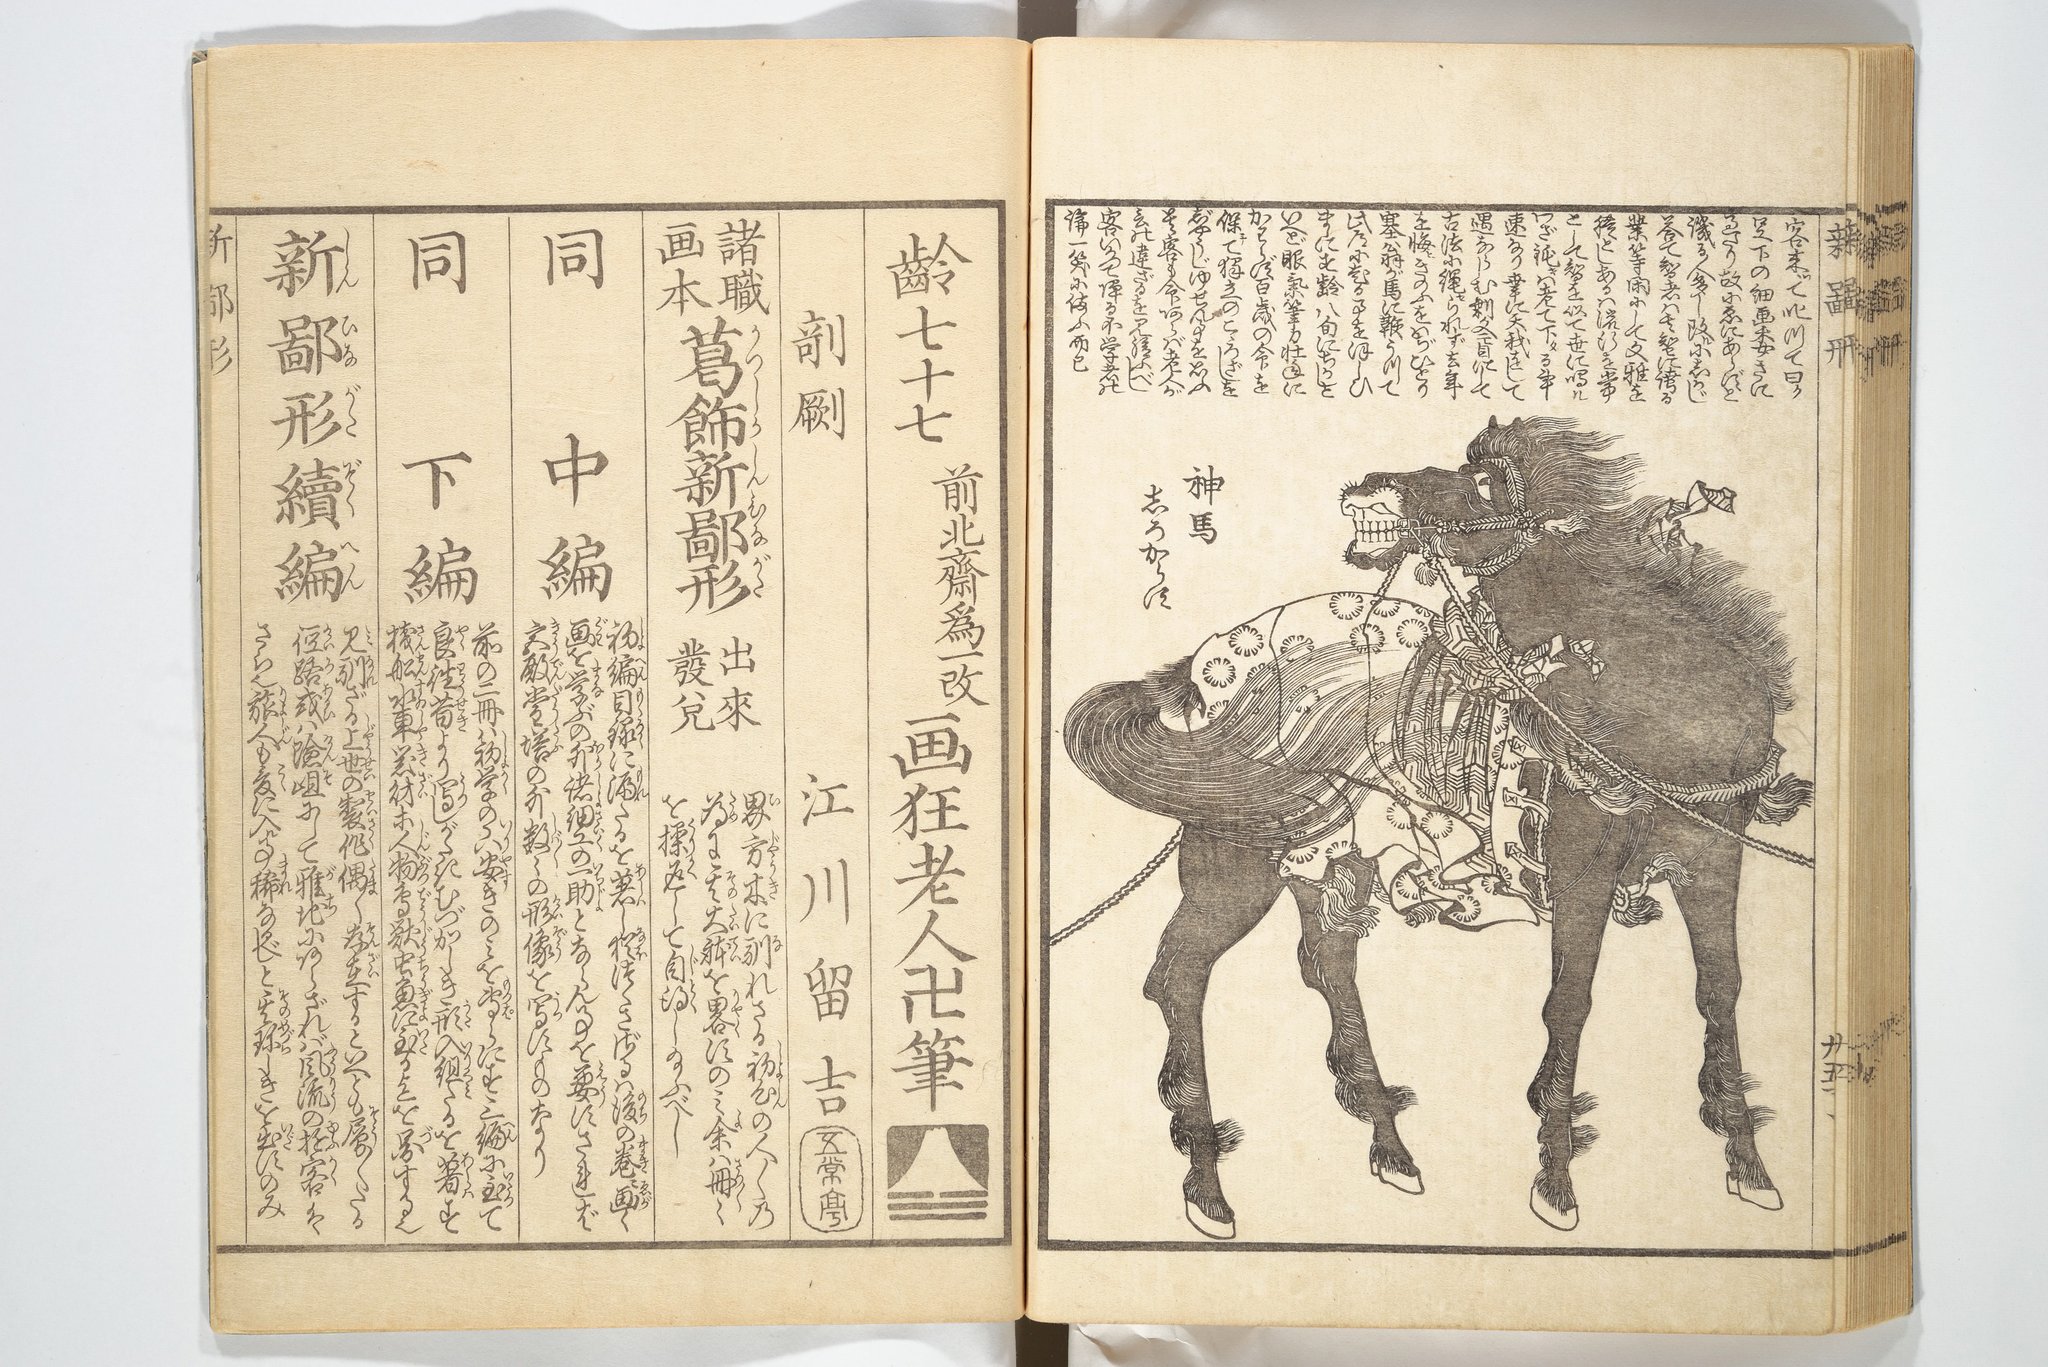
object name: illustrated book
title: Picture Book of New Designs for the Various Crafts (Shōshoku ehon Katsushika shin hinagata) 諸職絵本葛飾新鄙形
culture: japanese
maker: katsushika hokusai 葛飾北斎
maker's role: artist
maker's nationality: japanese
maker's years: 1760-1849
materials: ink, paper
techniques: woodblock print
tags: horses